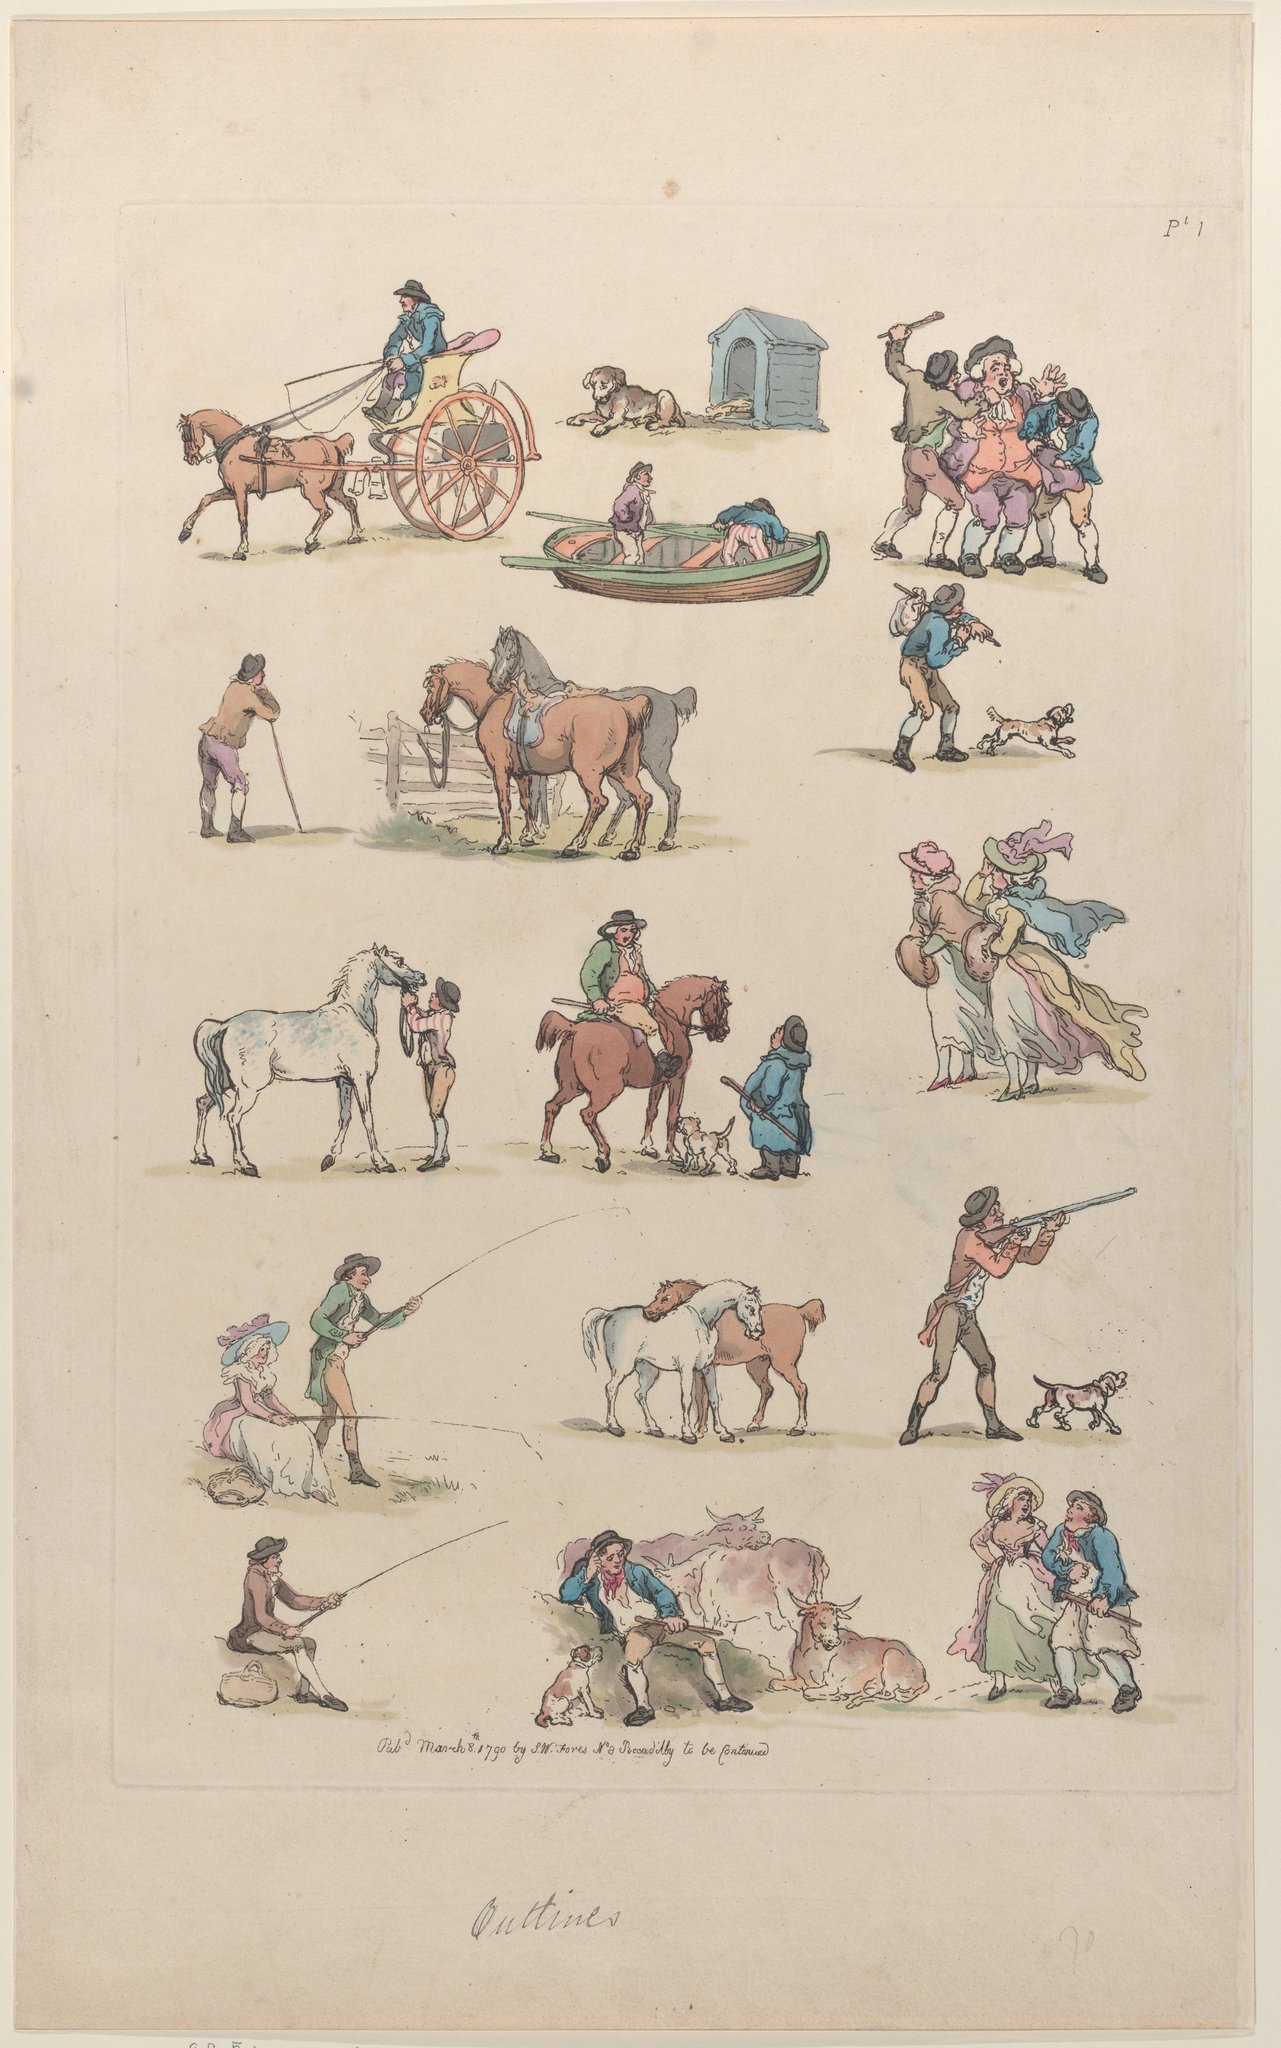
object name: print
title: Plate 1, Outlines of Figures, Landscapes and Cattle...for the Use of Learners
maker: thomas rowlandson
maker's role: artist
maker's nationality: british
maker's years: 1757-1827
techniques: etching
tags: men,women,dogs,horses,carriages